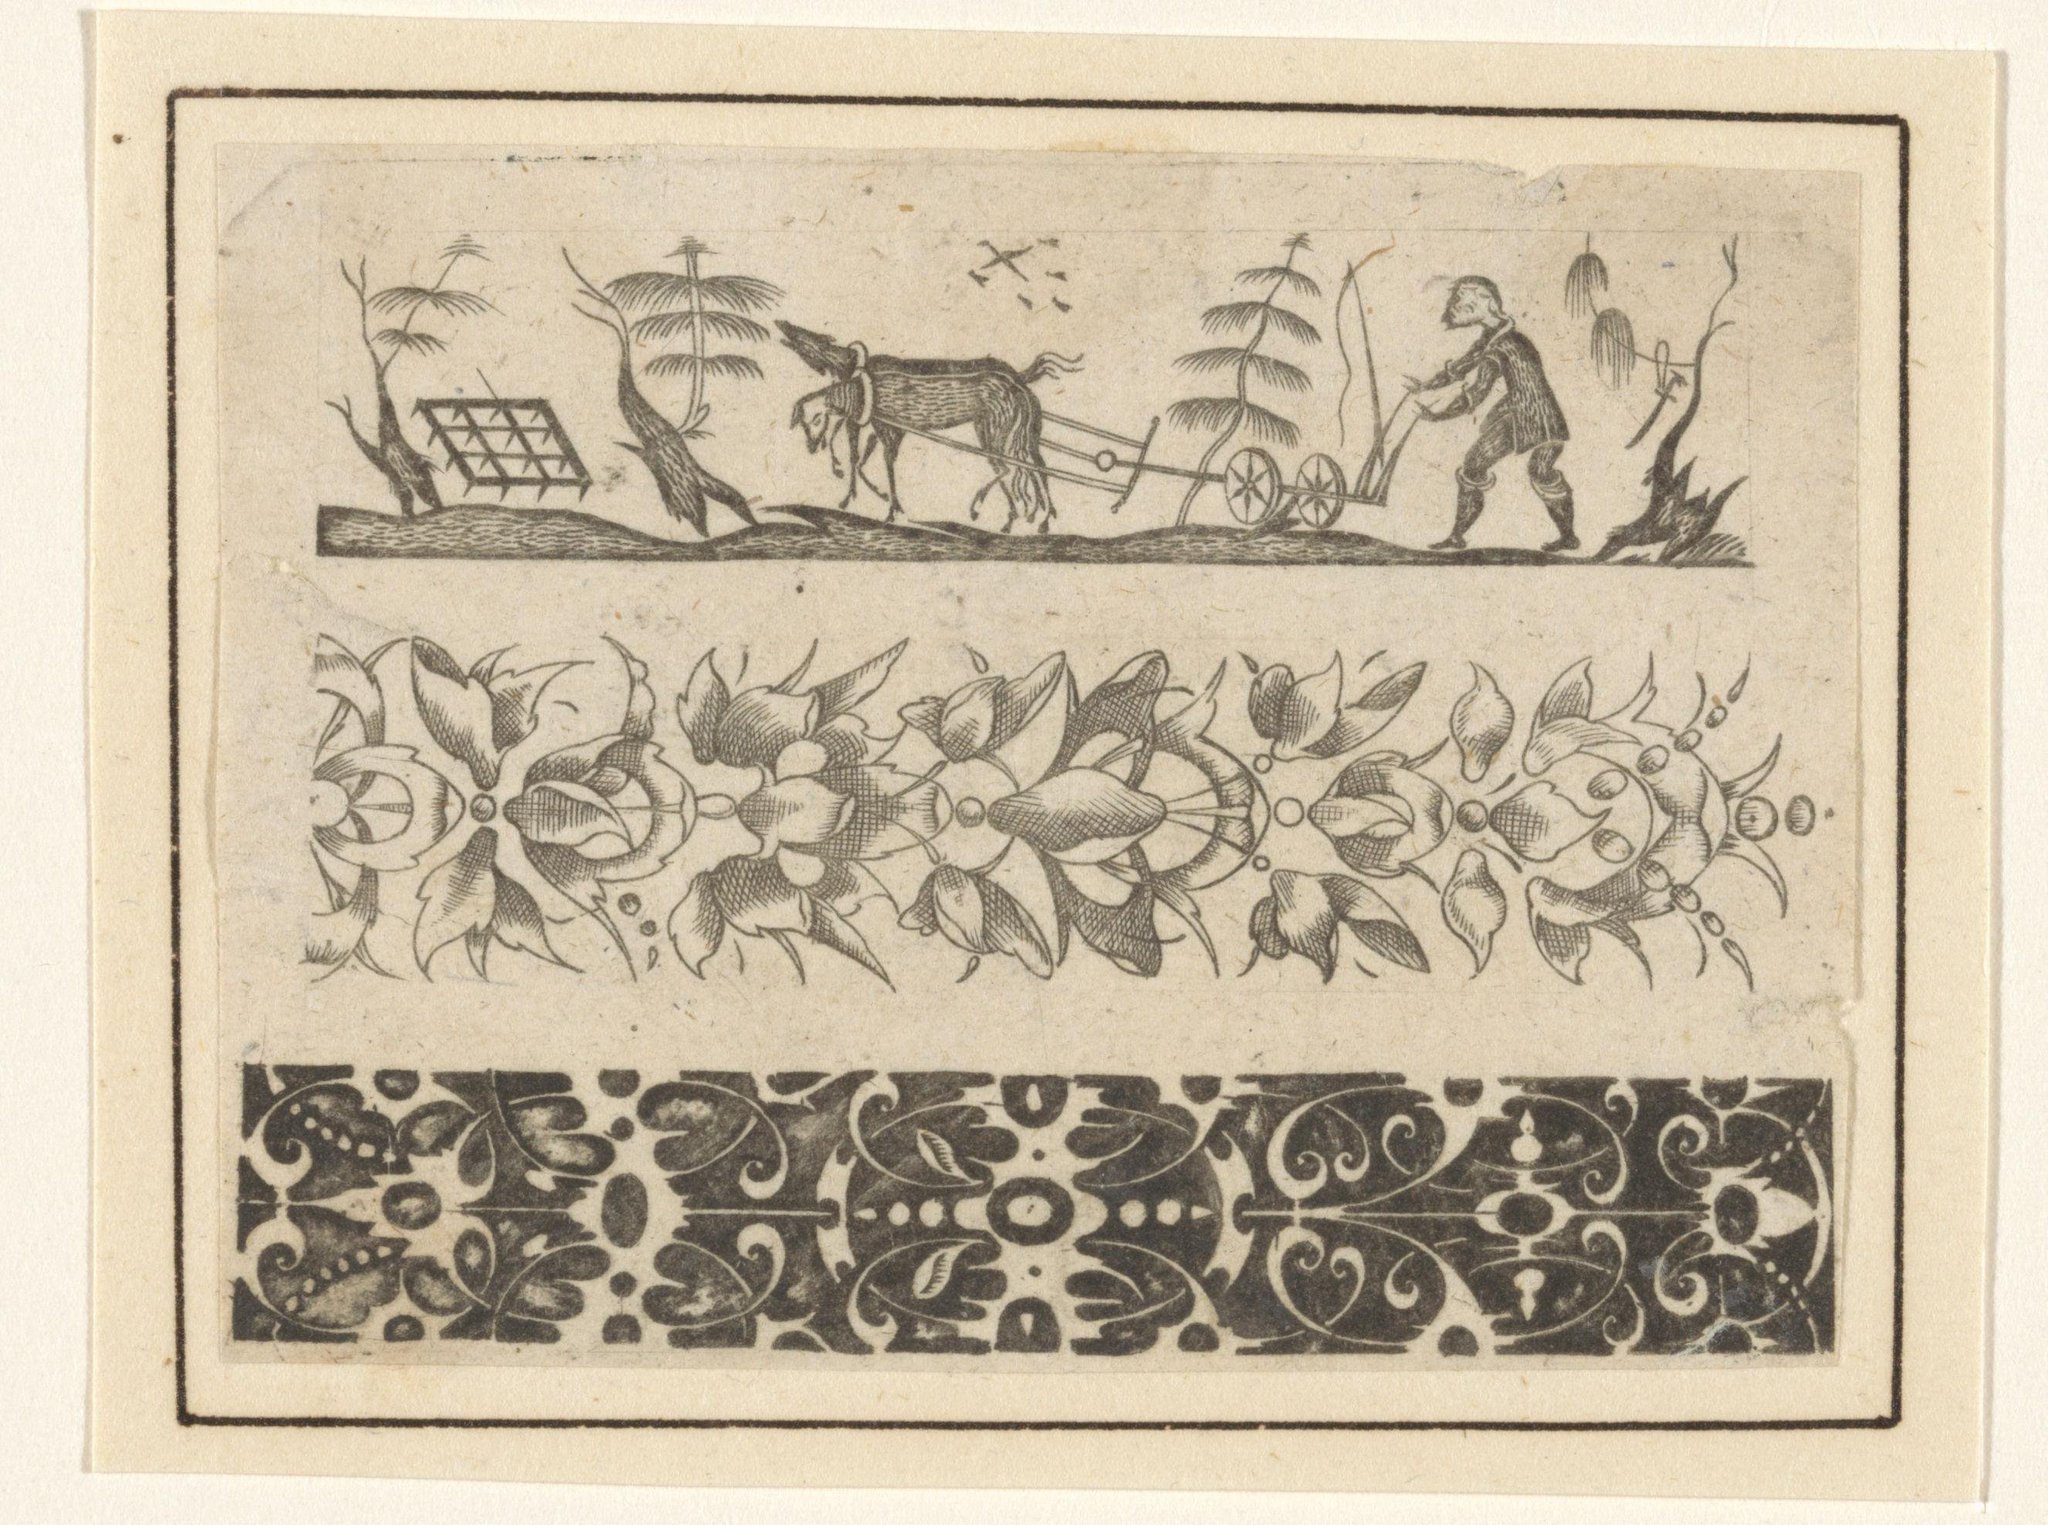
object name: ornament print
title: Ornament voor edelsmeedwerk met vogels, insecten en figuren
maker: henri toutin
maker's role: miniatuurschilder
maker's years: 1614-1683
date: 1628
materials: paper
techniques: engraving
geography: france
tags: ploughing, ornament derived from plant forms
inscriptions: collector's mark: Lugt 2760, collector's mark: Lugt 2228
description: Ornament voor edelsmeedwerk met drie banden met vogels, insecten en figuren. Prent nr. 6 uit reeks van 7 gepubliceerd in 1628 onder vermelding van de leeftijd van de kunstenaar: 'á l'äge de 14 ans'.